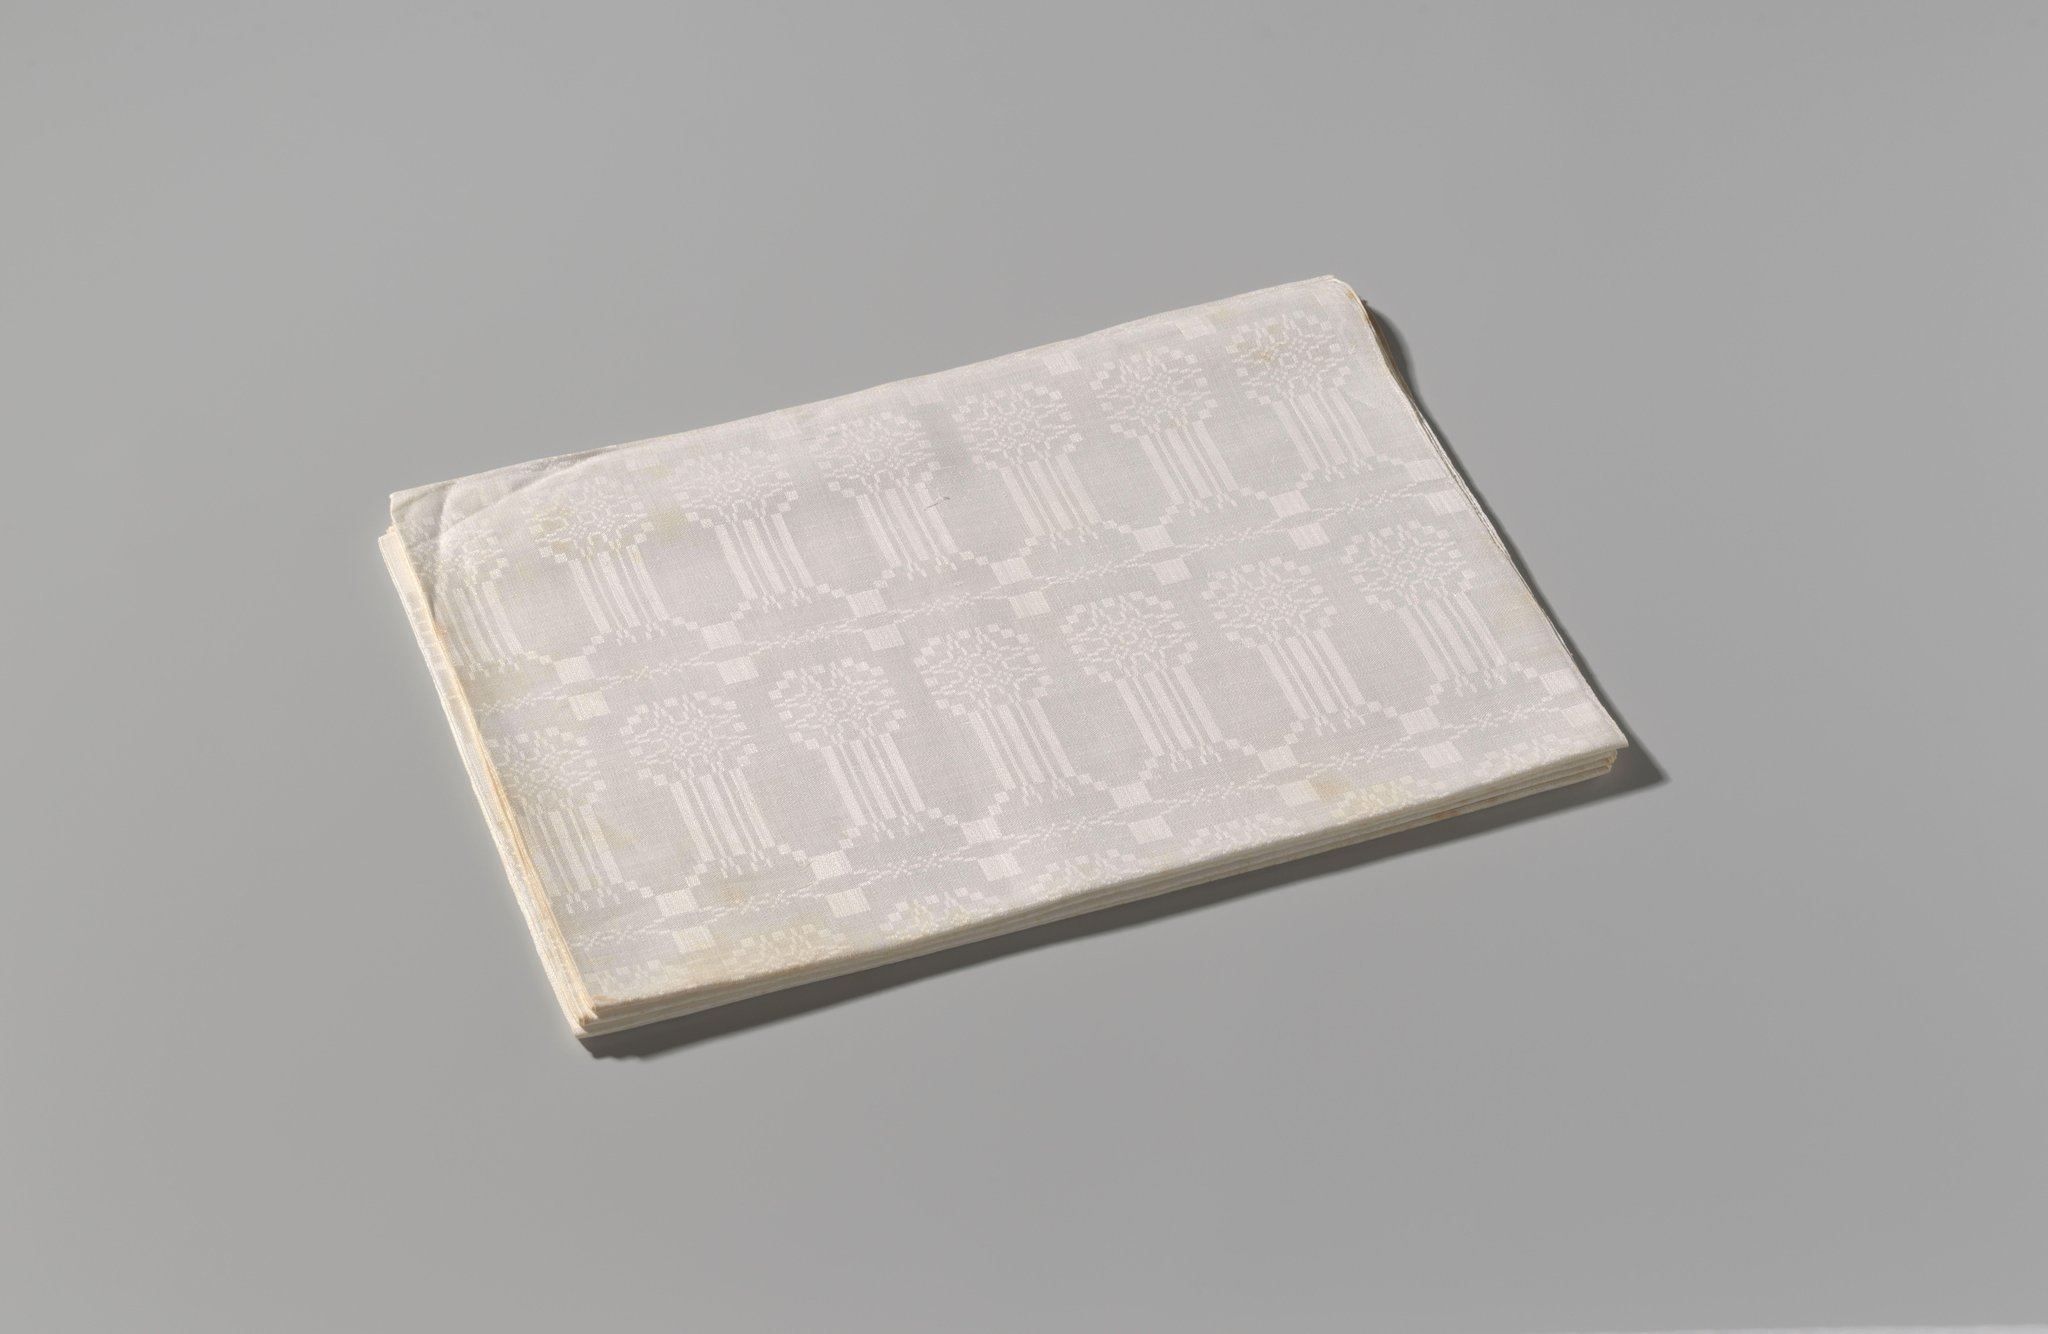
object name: tablecloth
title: Tafellaken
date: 1700-1799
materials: linen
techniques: peeled fabric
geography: netherlands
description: Wit linnen tafellaken met een pellen patroon z.g. Oranjeboom, merk IG 3 WH 2oonl.